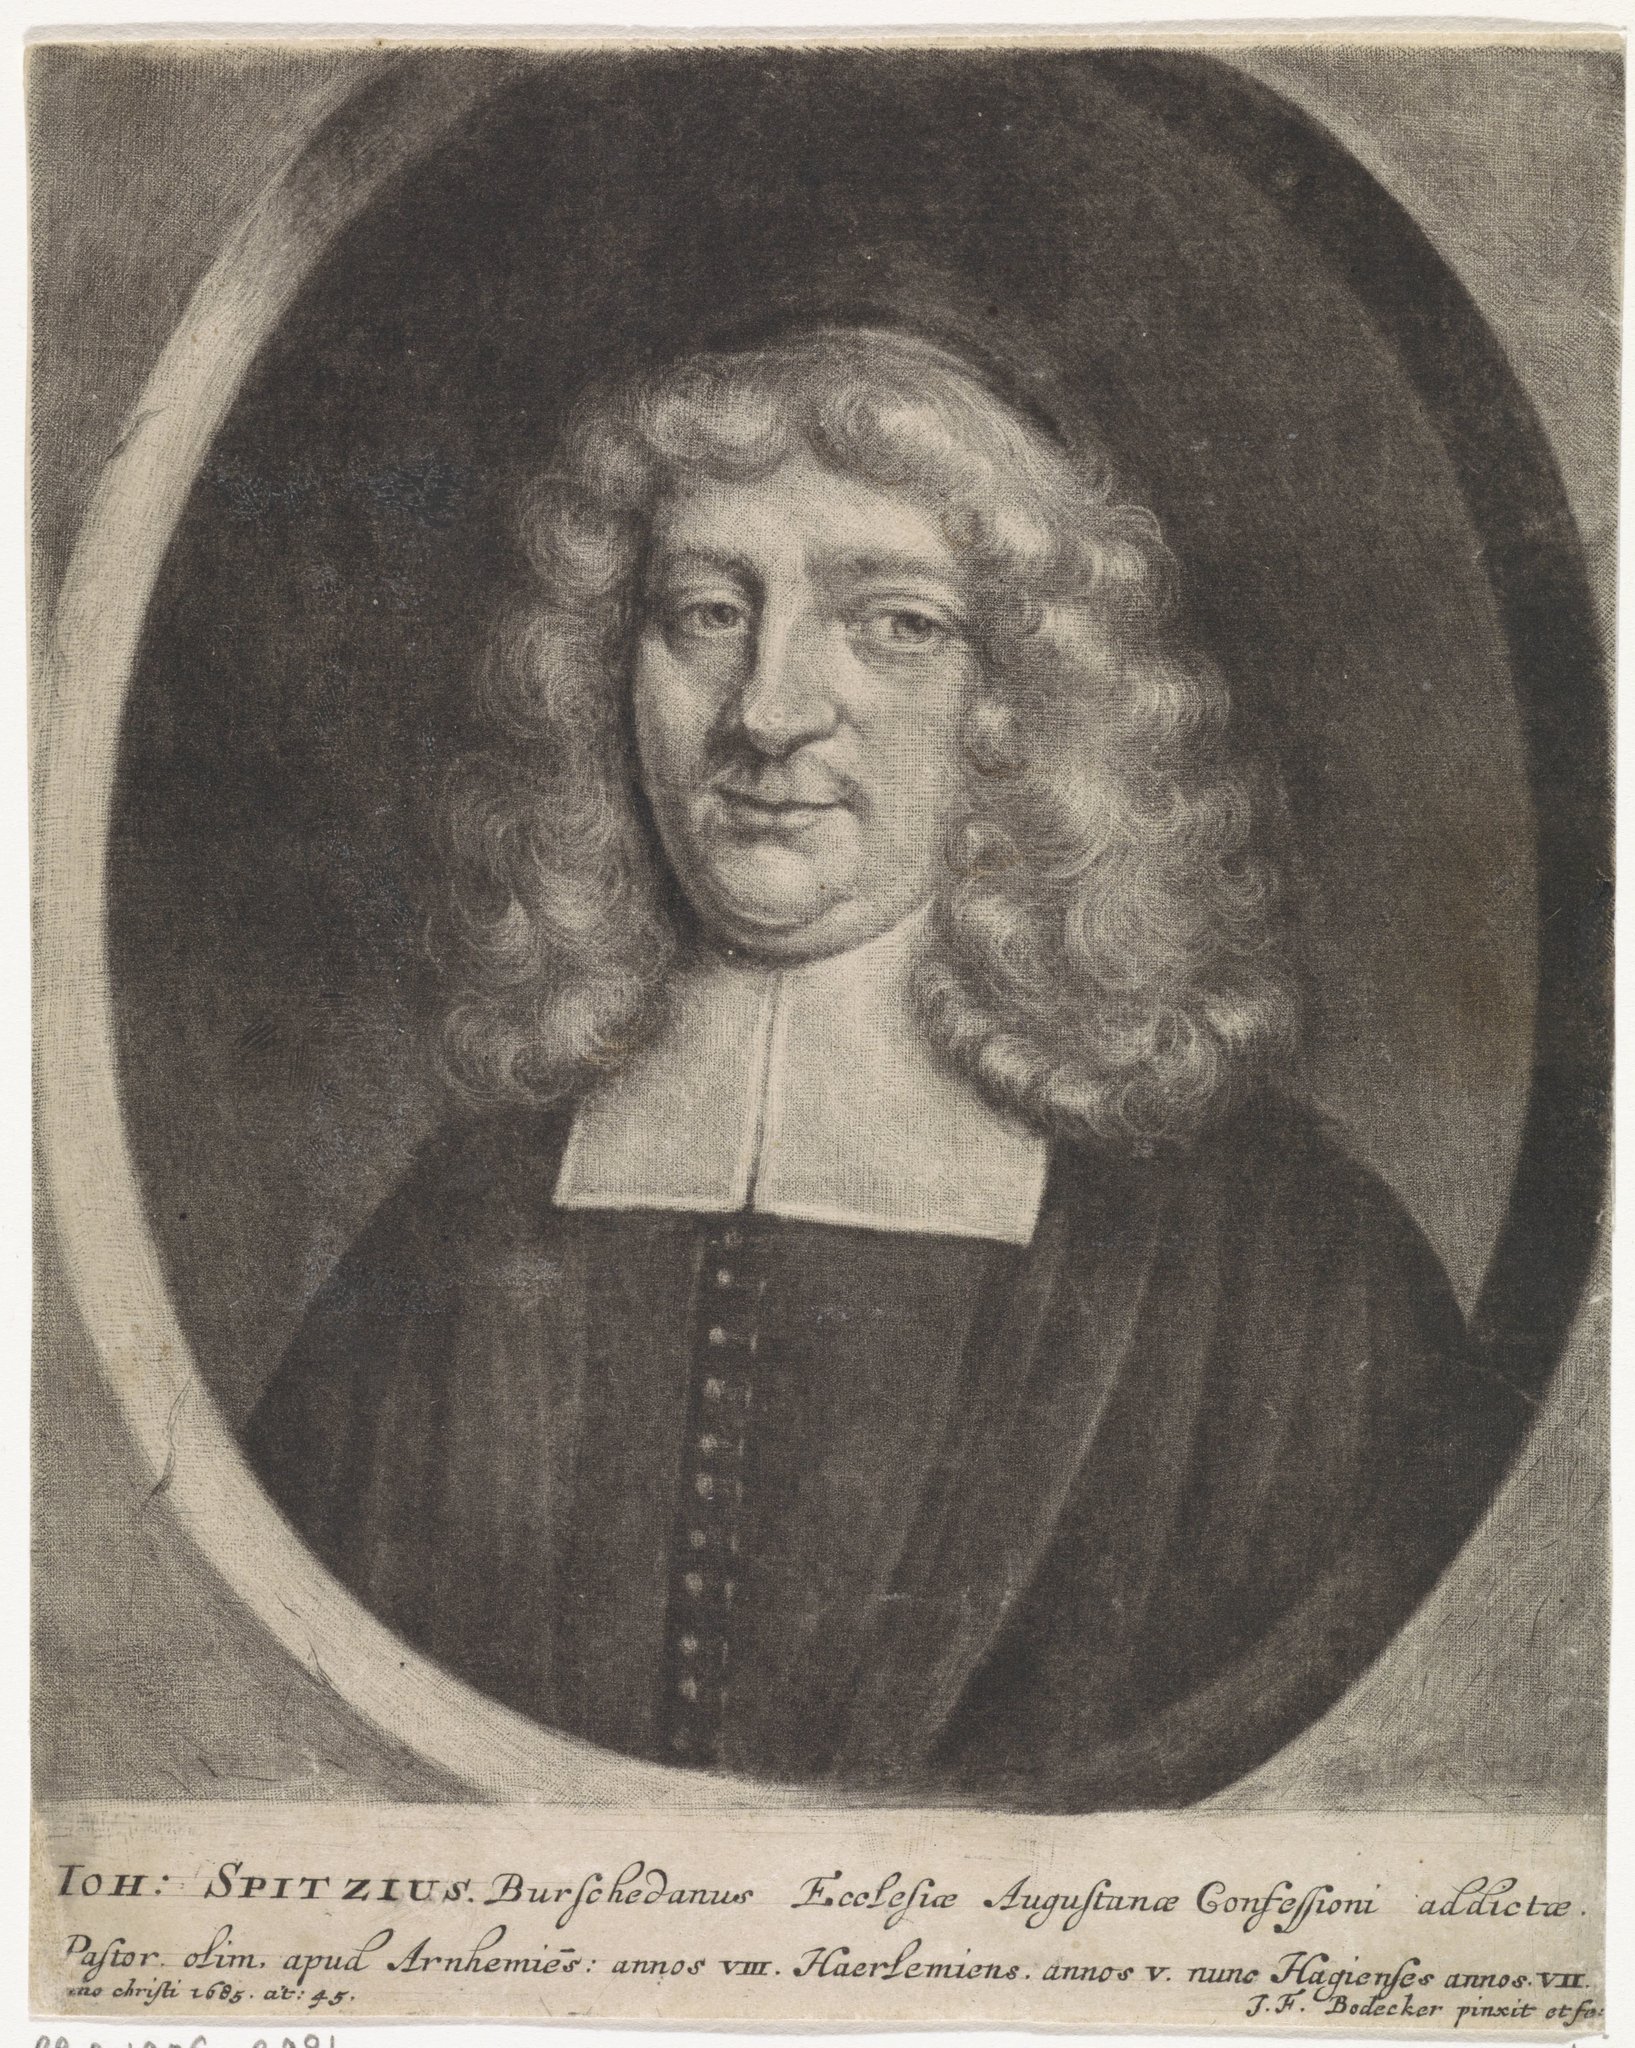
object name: print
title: Portret van Johan Spitzius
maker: johann friedrich bodecker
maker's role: print maker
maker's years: 1658-1727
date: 1685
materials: paper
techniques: engraving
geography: the hague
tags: johan spitzius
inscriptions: collector's mark: Lugt 2228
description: Portret van Johan Spitzius op 45-jarige leeftijd. Hij was Lutherse predikant in Arnhem, Haarlem en Den Haag. In de marge zijn naam, leeftijd en titels in het Latijn.